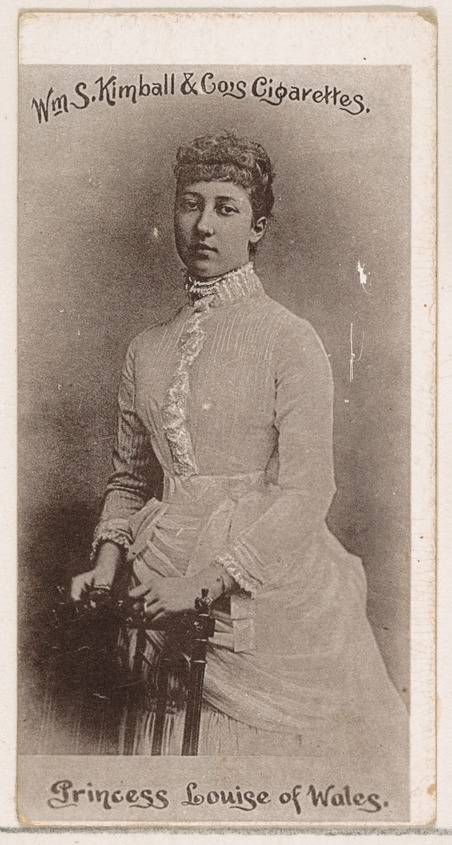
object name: print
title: Princess Louise of Wales, from the Actresses series (N190) issued by Wm. S. Kimball & Co.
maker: william s. kimball & company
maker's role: publisher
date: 1889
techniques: lithography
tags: portraits,women,actresses